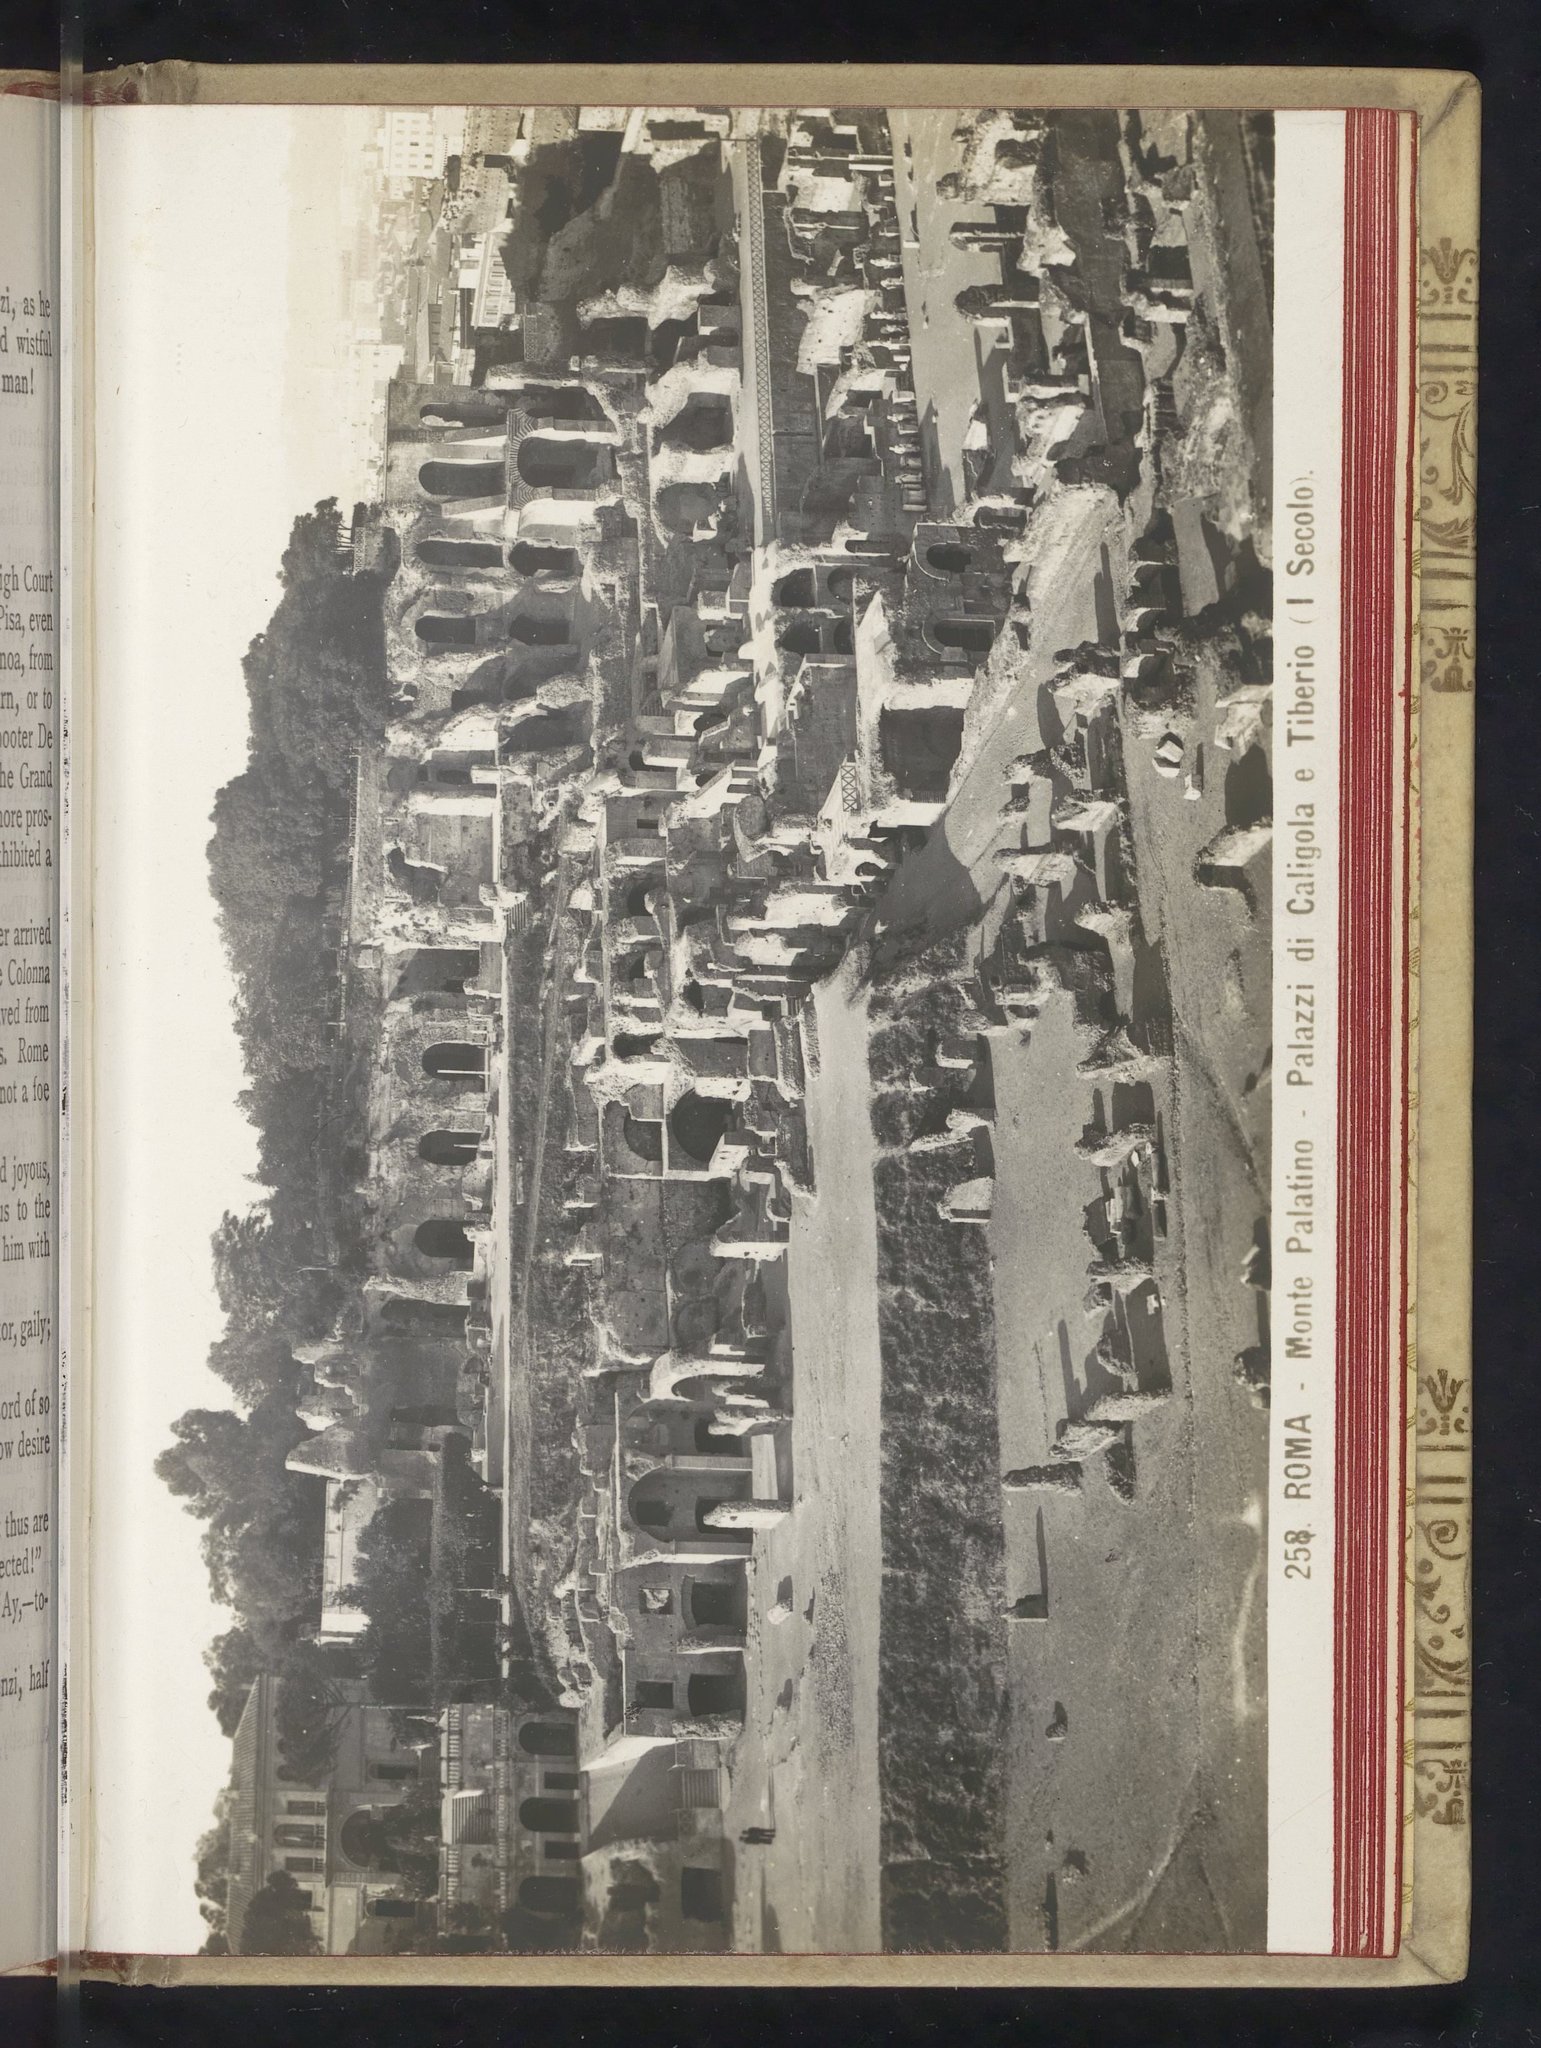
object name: photograph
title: Ruïne van de Domus Tiberiana op de Palatijn te Rome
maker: Anonymous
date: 1895-1915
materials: photographic support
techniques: gelatin silver print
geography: palatine hill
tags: ruin of a building ~ architecture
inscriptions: number: ‘258.’